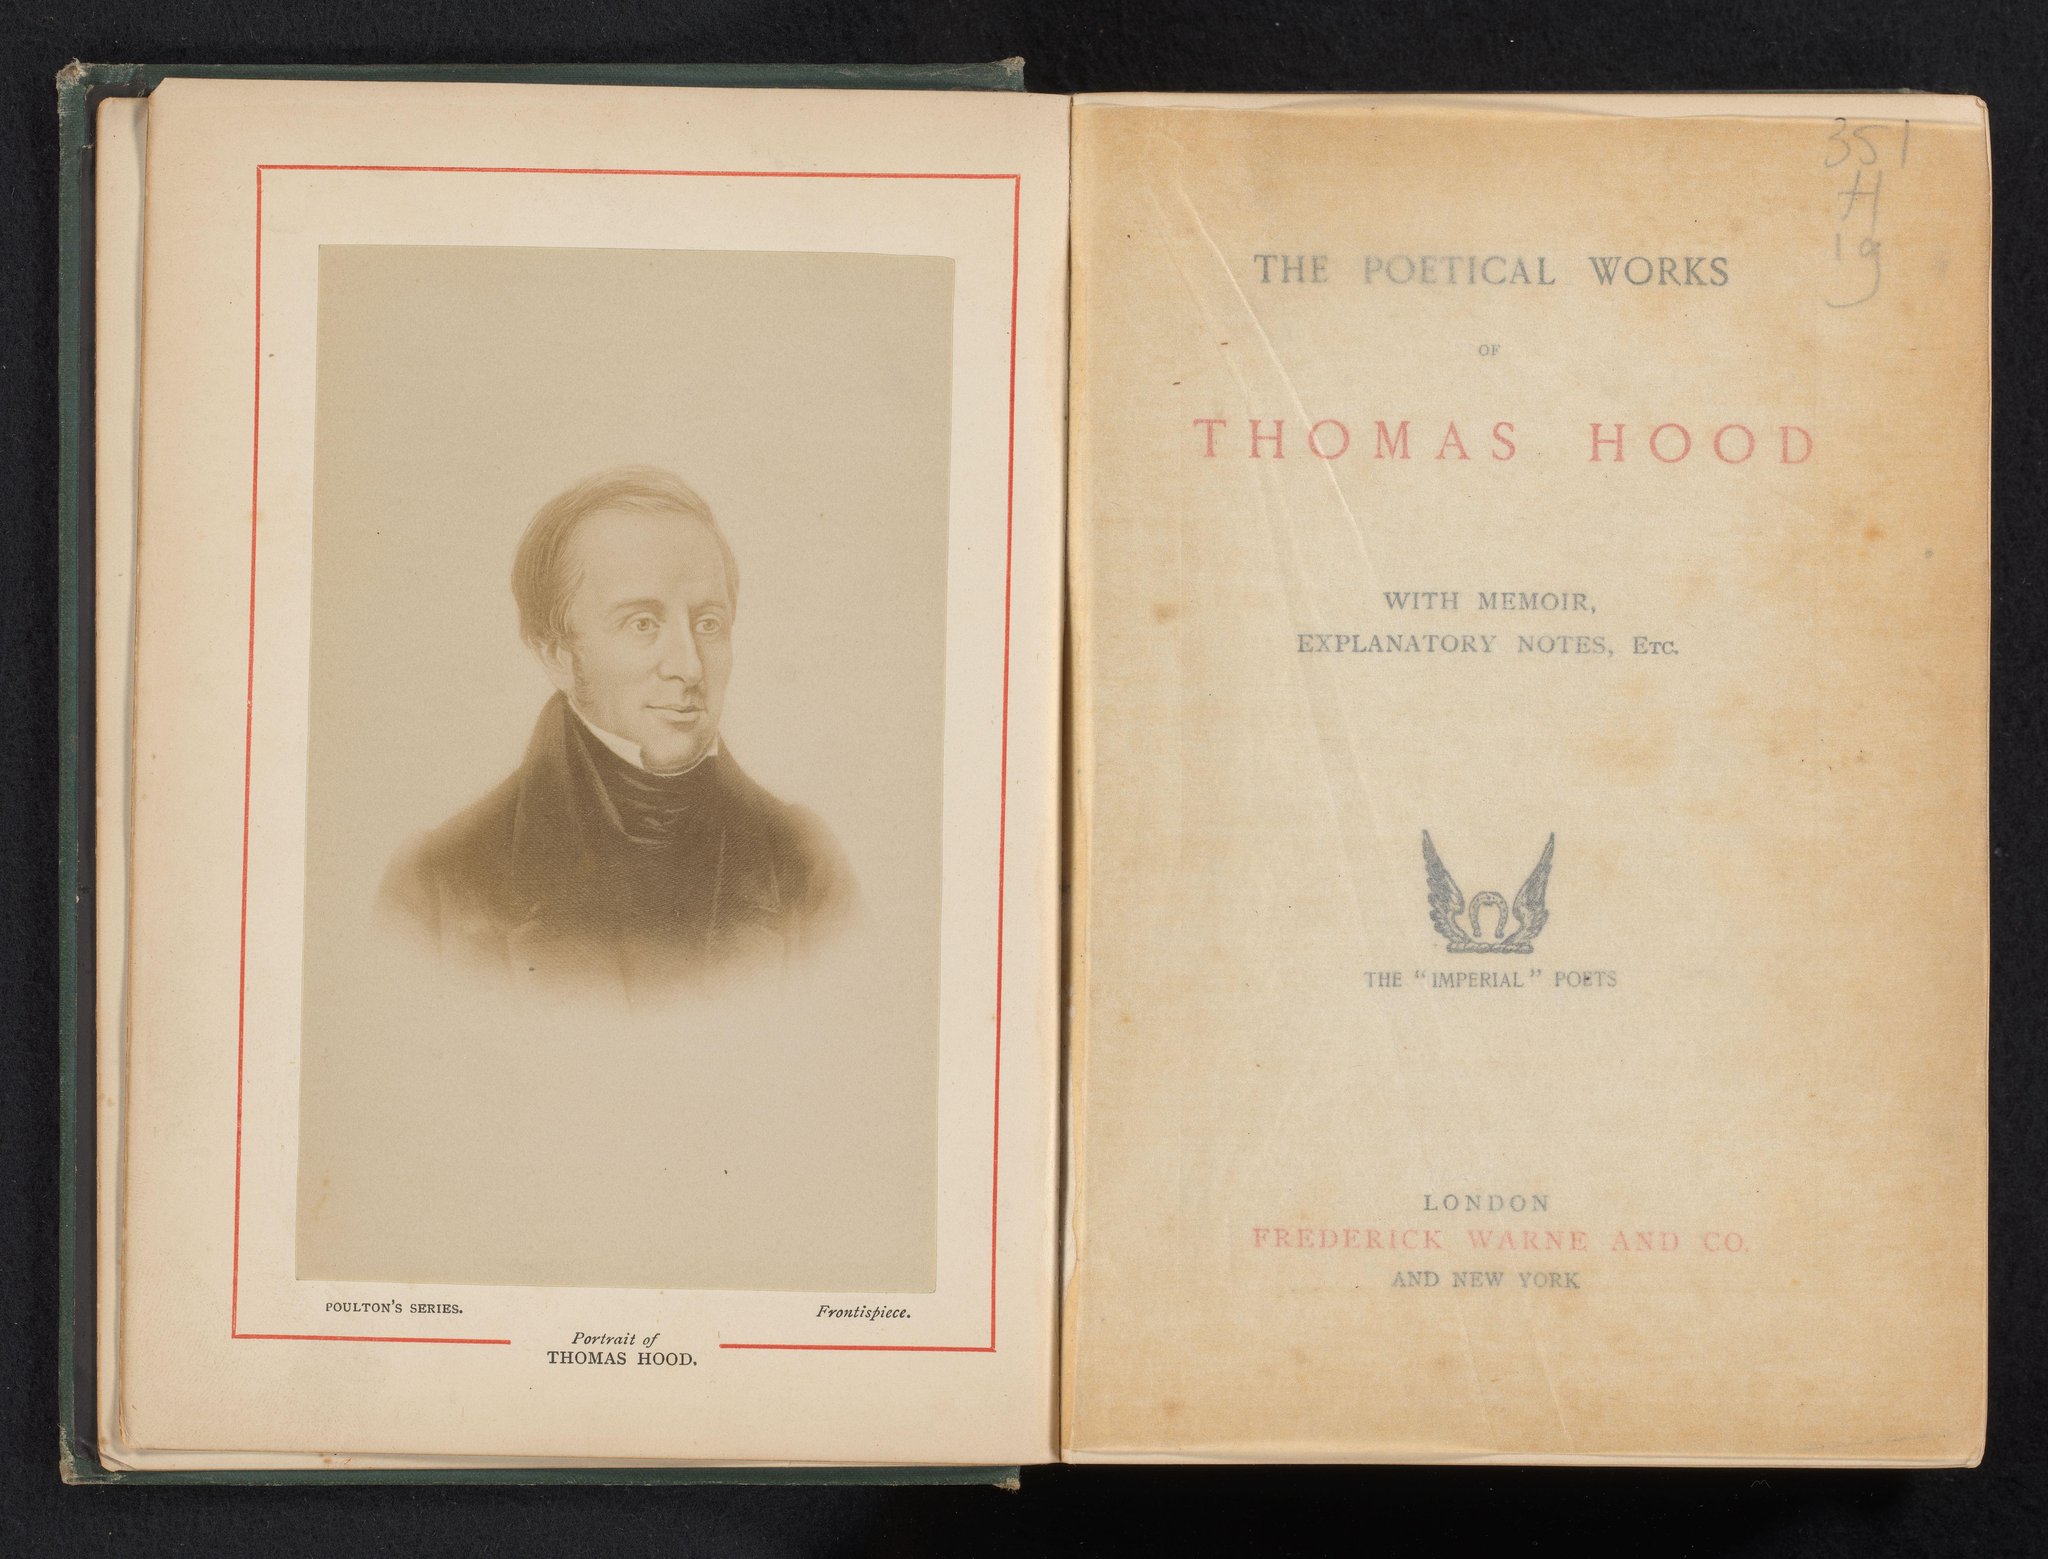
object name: reproduction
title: Portrait of Thomas Hood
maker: poulton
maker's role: fotograaf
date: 1870-1890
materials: paper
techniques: albumen print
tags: london, thomas hood, portrait of a writer, picture, painting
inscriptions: inscription: ‘POULTON'S SERIES/ Frontispiece.’